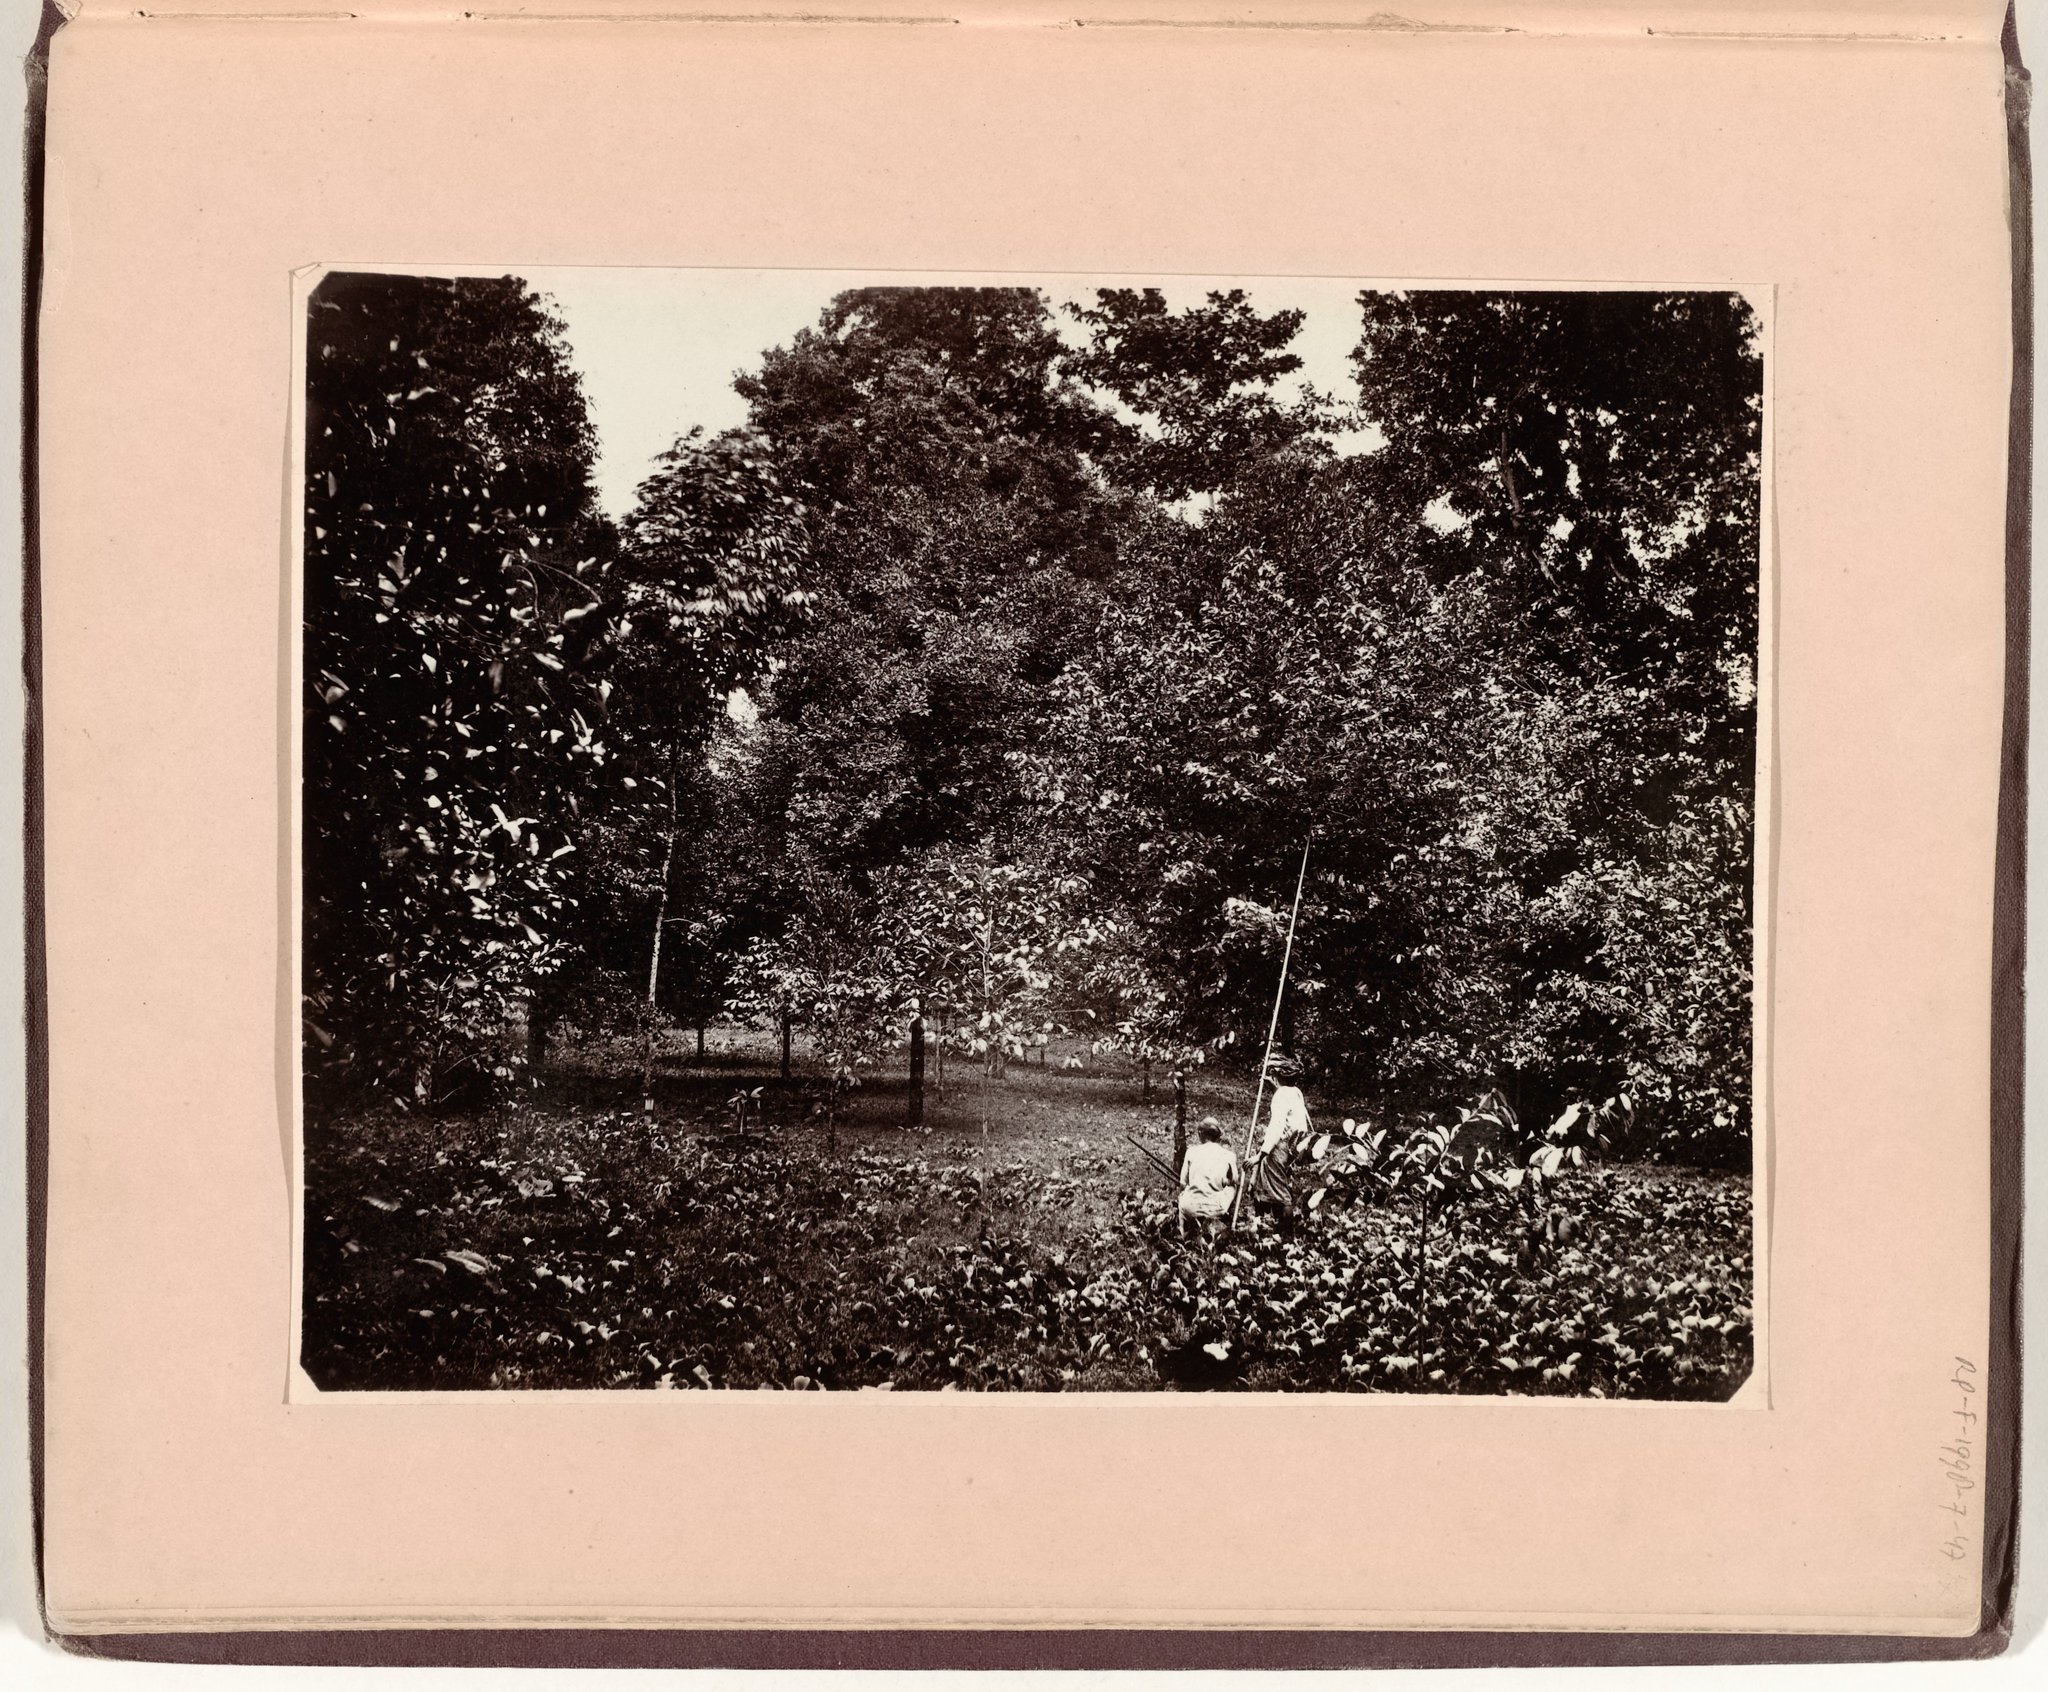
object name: album leaf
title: Oogsten van nootmuskaat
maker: c. dietrich (fotograaf)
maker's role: fotograaf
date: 1875-1890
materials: cardboard, paper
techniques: albumen print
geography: banda islands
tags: fruits: nuts, reaping, picking, mowing ~ harvest